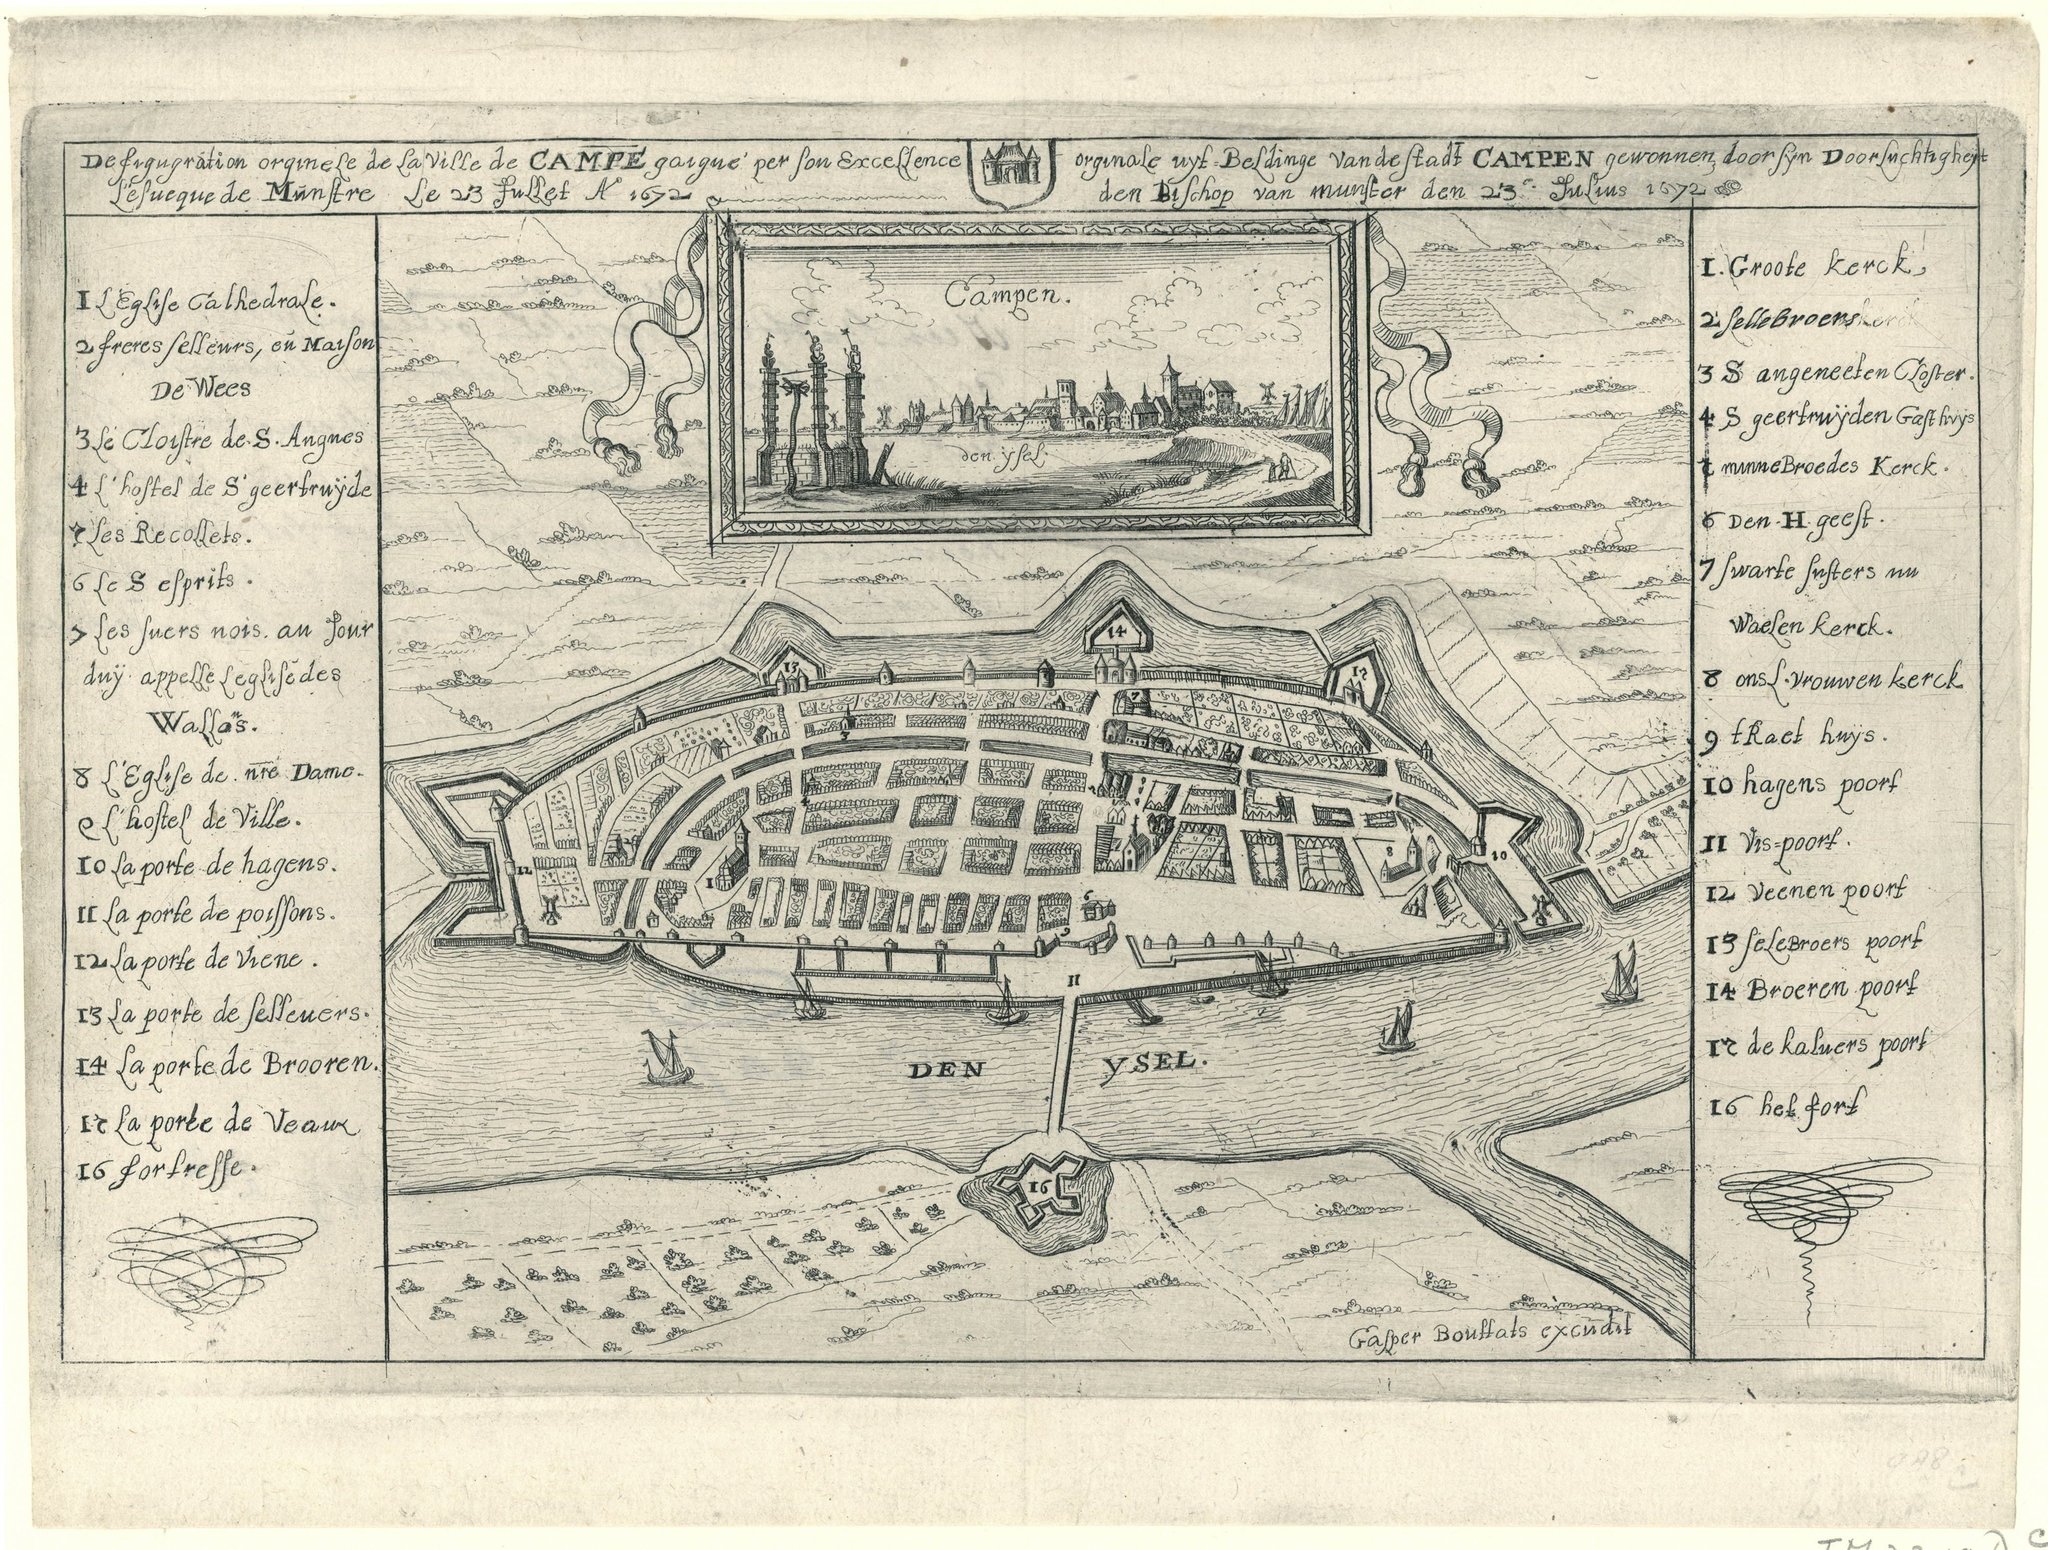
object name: print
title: Plattegrond van Kampen, veroverd door de bisschop van Munster in 1672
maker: gaspar bouttats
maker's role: print maker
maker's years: 1640-1695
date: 1672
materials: paper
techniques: etching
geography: antwerp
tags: maps of cities, rampjaar (disaster year)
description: Plattegrond van en gezicht op de stad Kampen, ingenomen door de troepen van de bisschop van Munster op 23 juli 1672. Deze prent maakt deel uit van een groep van twaalf prenten, merendeels geëetst en uitgegeven door Gaspar Bouttats, met gezichten op vestingen en steden veroverd door de Fransen en de bisschop van Munster in 1672. Plattegrond met bijschriften en legenda's in Frans en Nederlands.